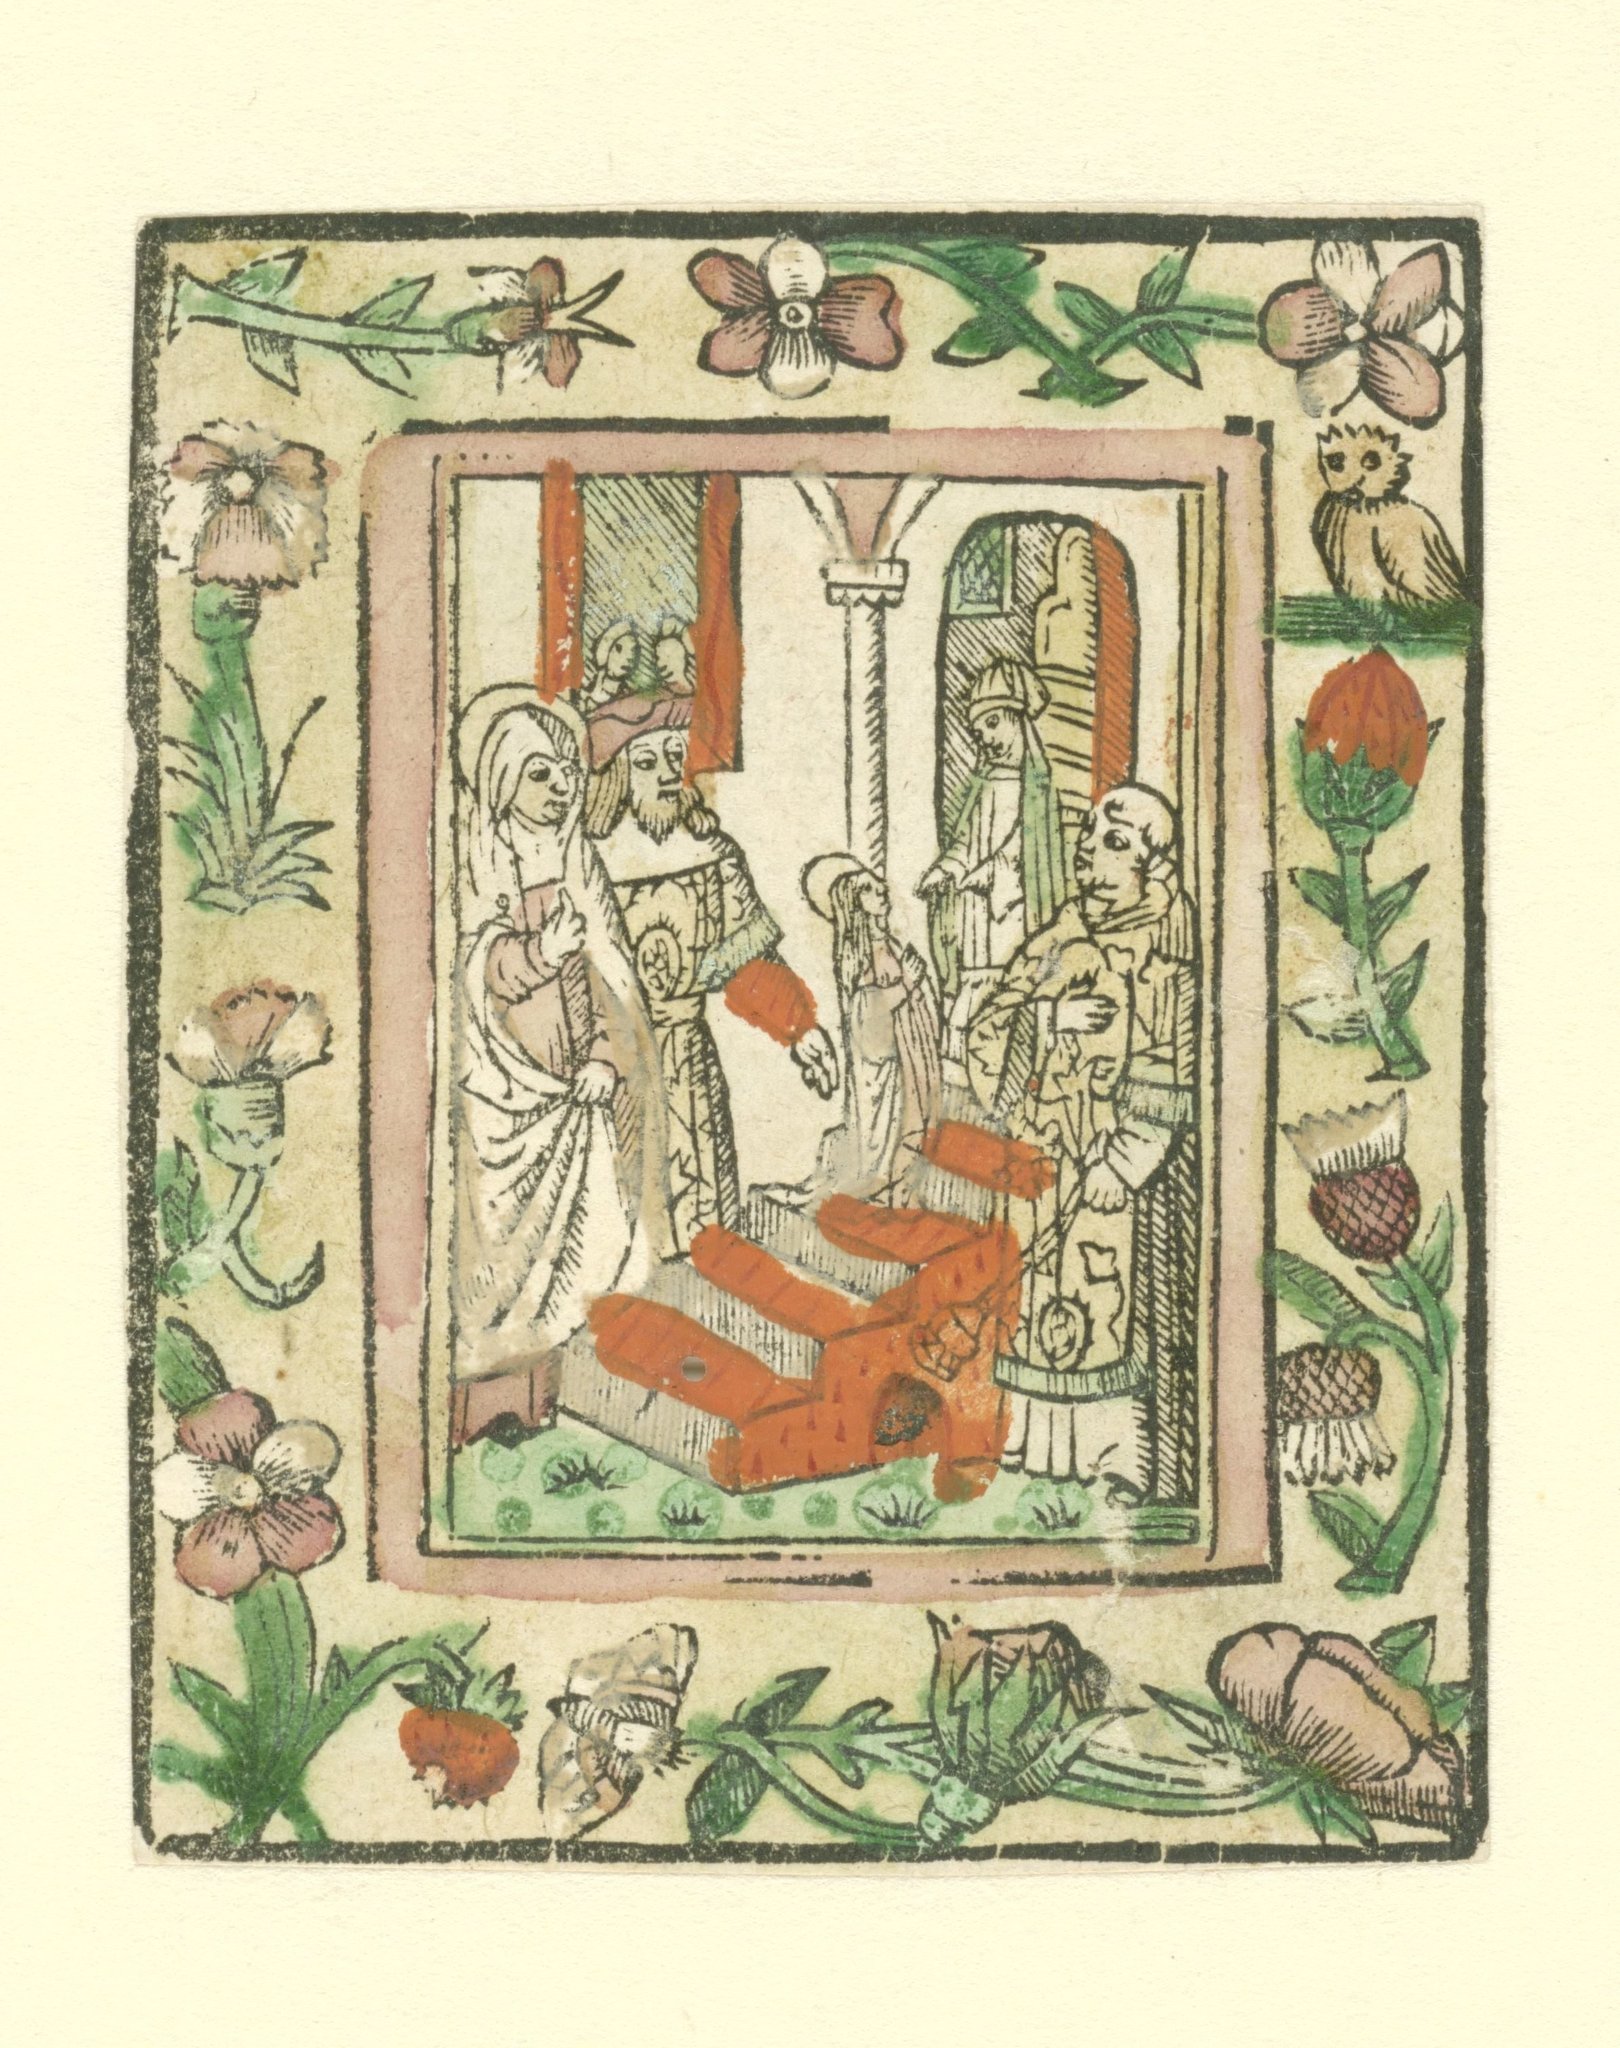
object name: print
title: Leven van Maria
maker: Anonymous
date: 1490-1510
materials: paper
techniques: hand coloring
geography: leiden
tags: dedication (or presentation) of mary in the temple: she ascends the steps and is received by the high priest, flowers ~ ornament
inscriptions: collector's mark: Lugt 2228a, inscription: ‘1’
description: Opdracht van Maria in de Tempel met rechts een priester en links Anna en Joachim. In een rand van bloemornamenten.